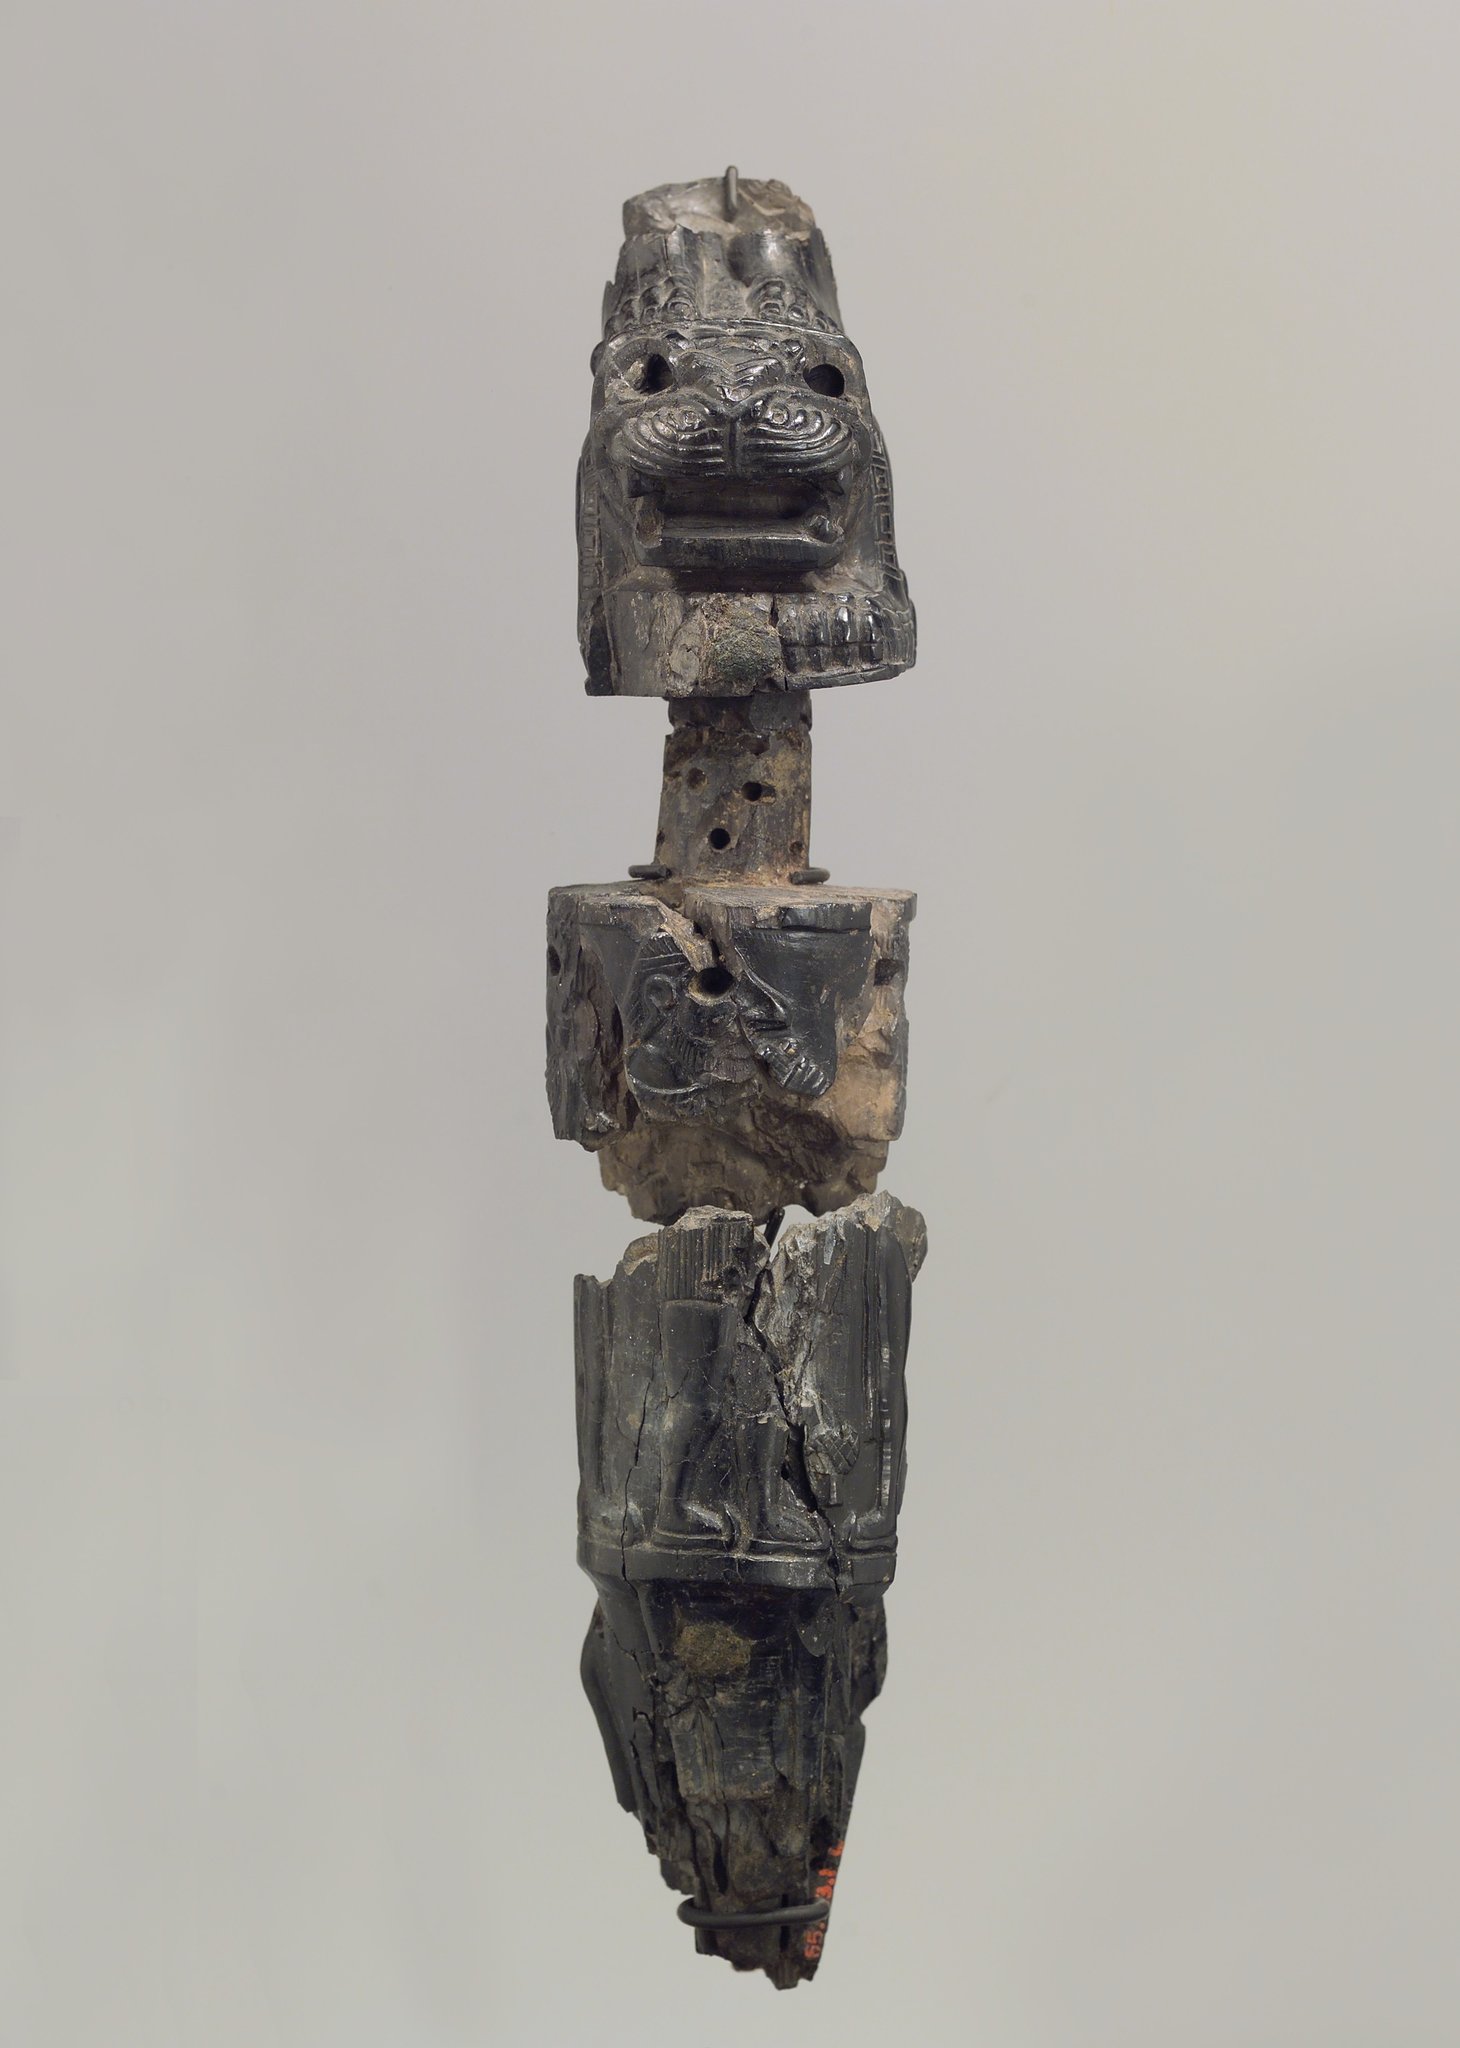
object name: furniture leg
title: Furniture leg (?) with a recumbent lion supporting a deity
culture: iranian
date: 900-801 BCE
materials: ivory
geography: iran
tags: lions